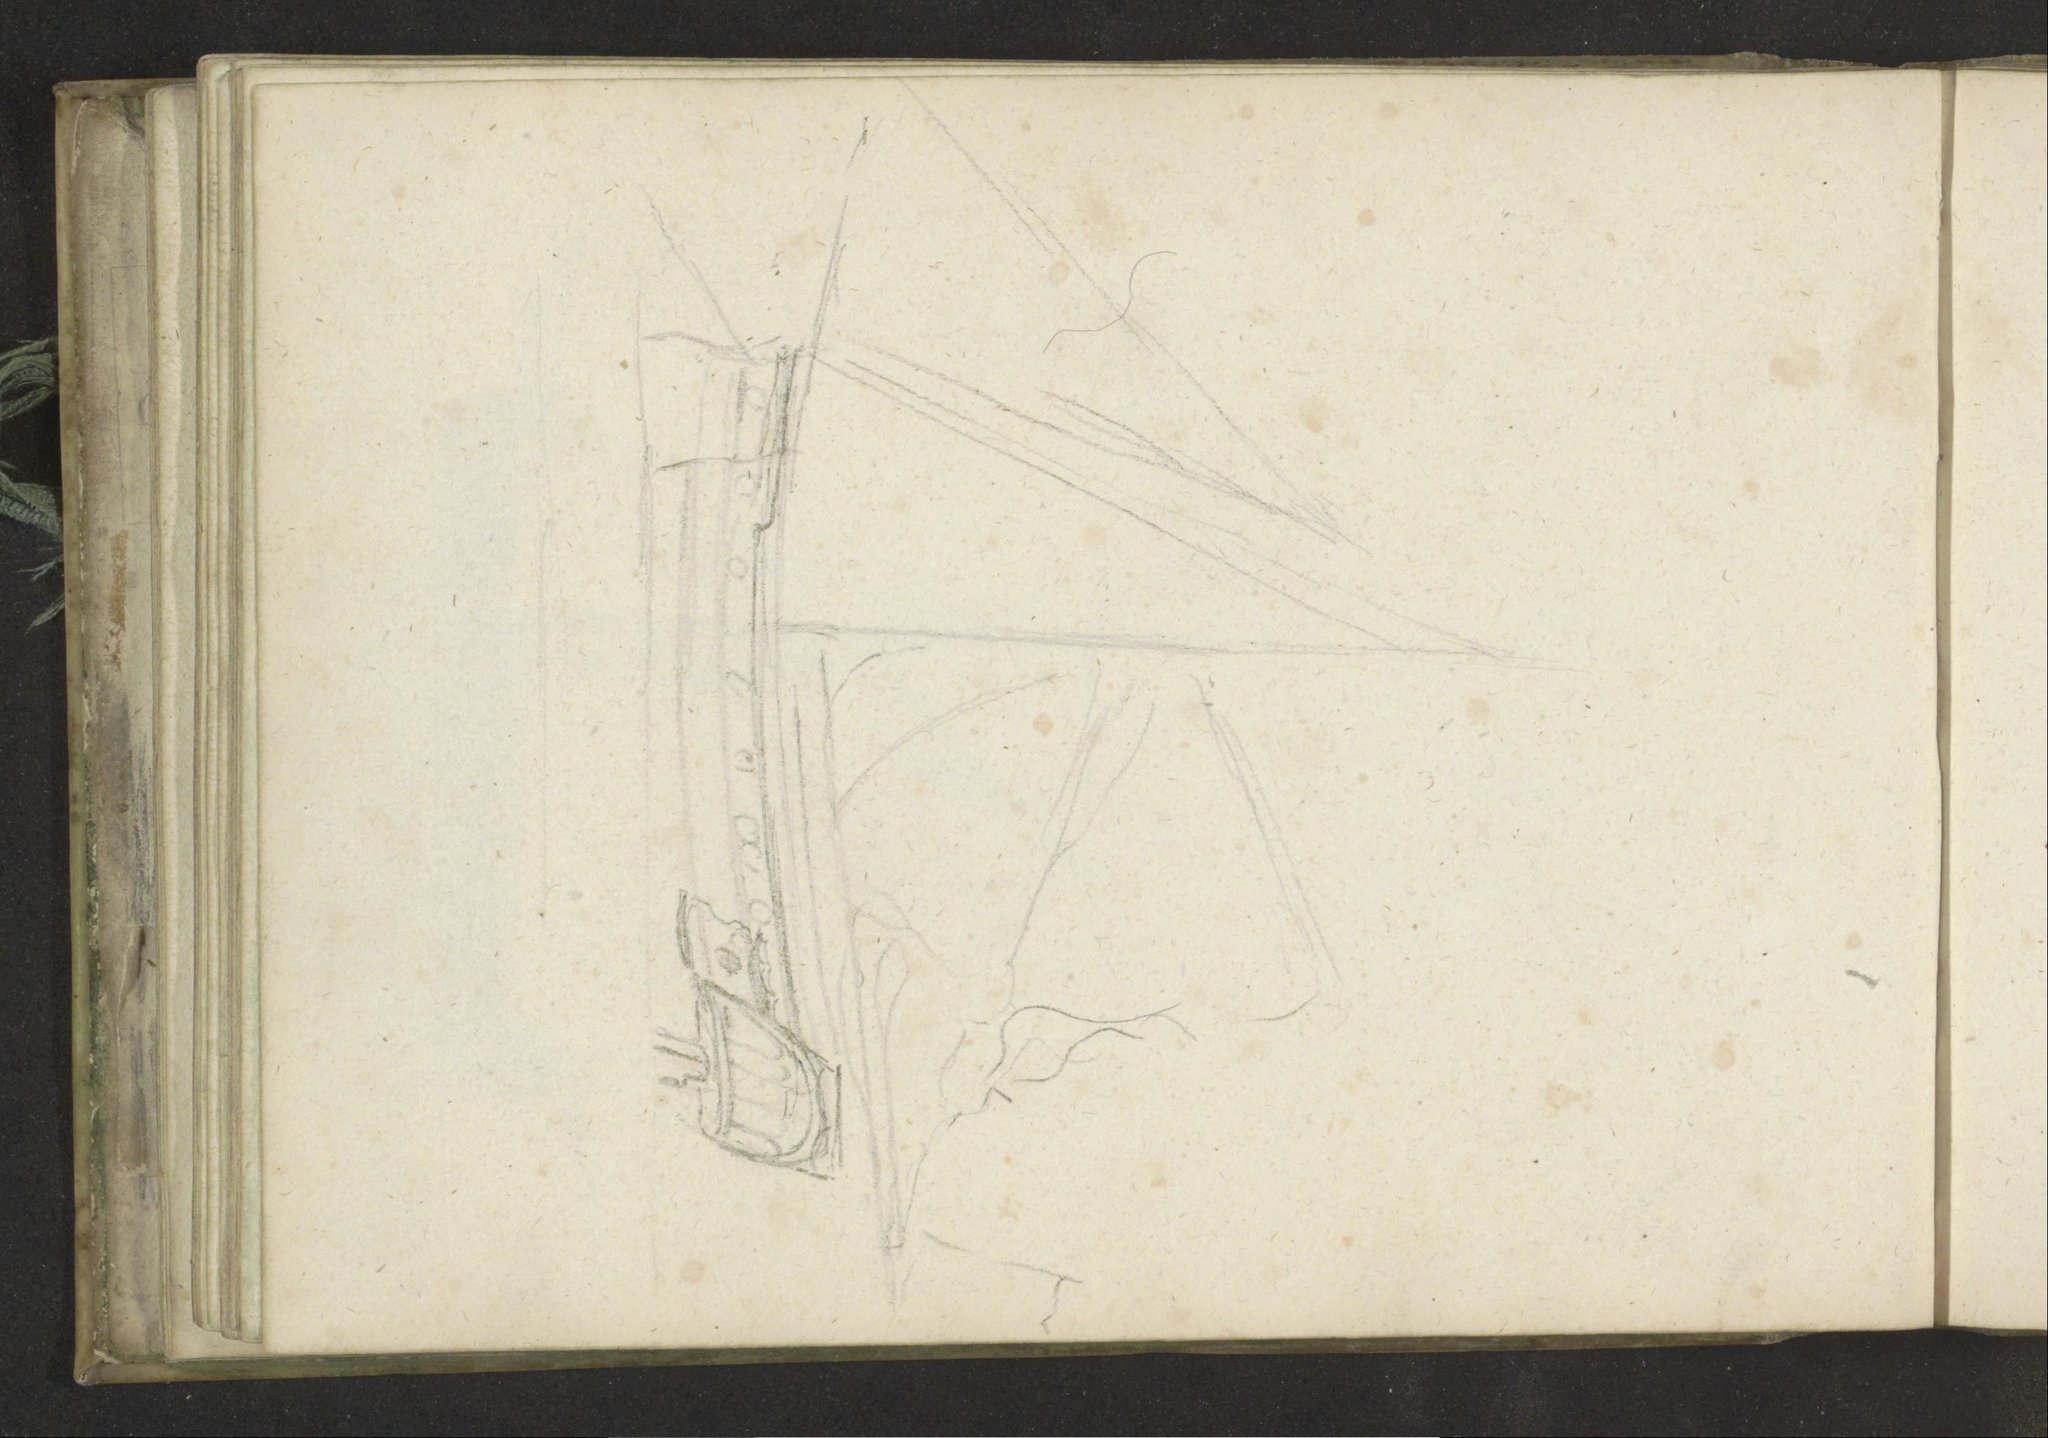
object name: sketchbook leaf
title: Zeilschip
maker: martinus schouman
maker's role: draughtsman, painter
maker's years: 1770-1848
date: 1780-1848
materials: paper, pencil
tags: sailing-ship, sailing-boat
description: Blad 29 verso uit een schetsboek met 53 bladen.